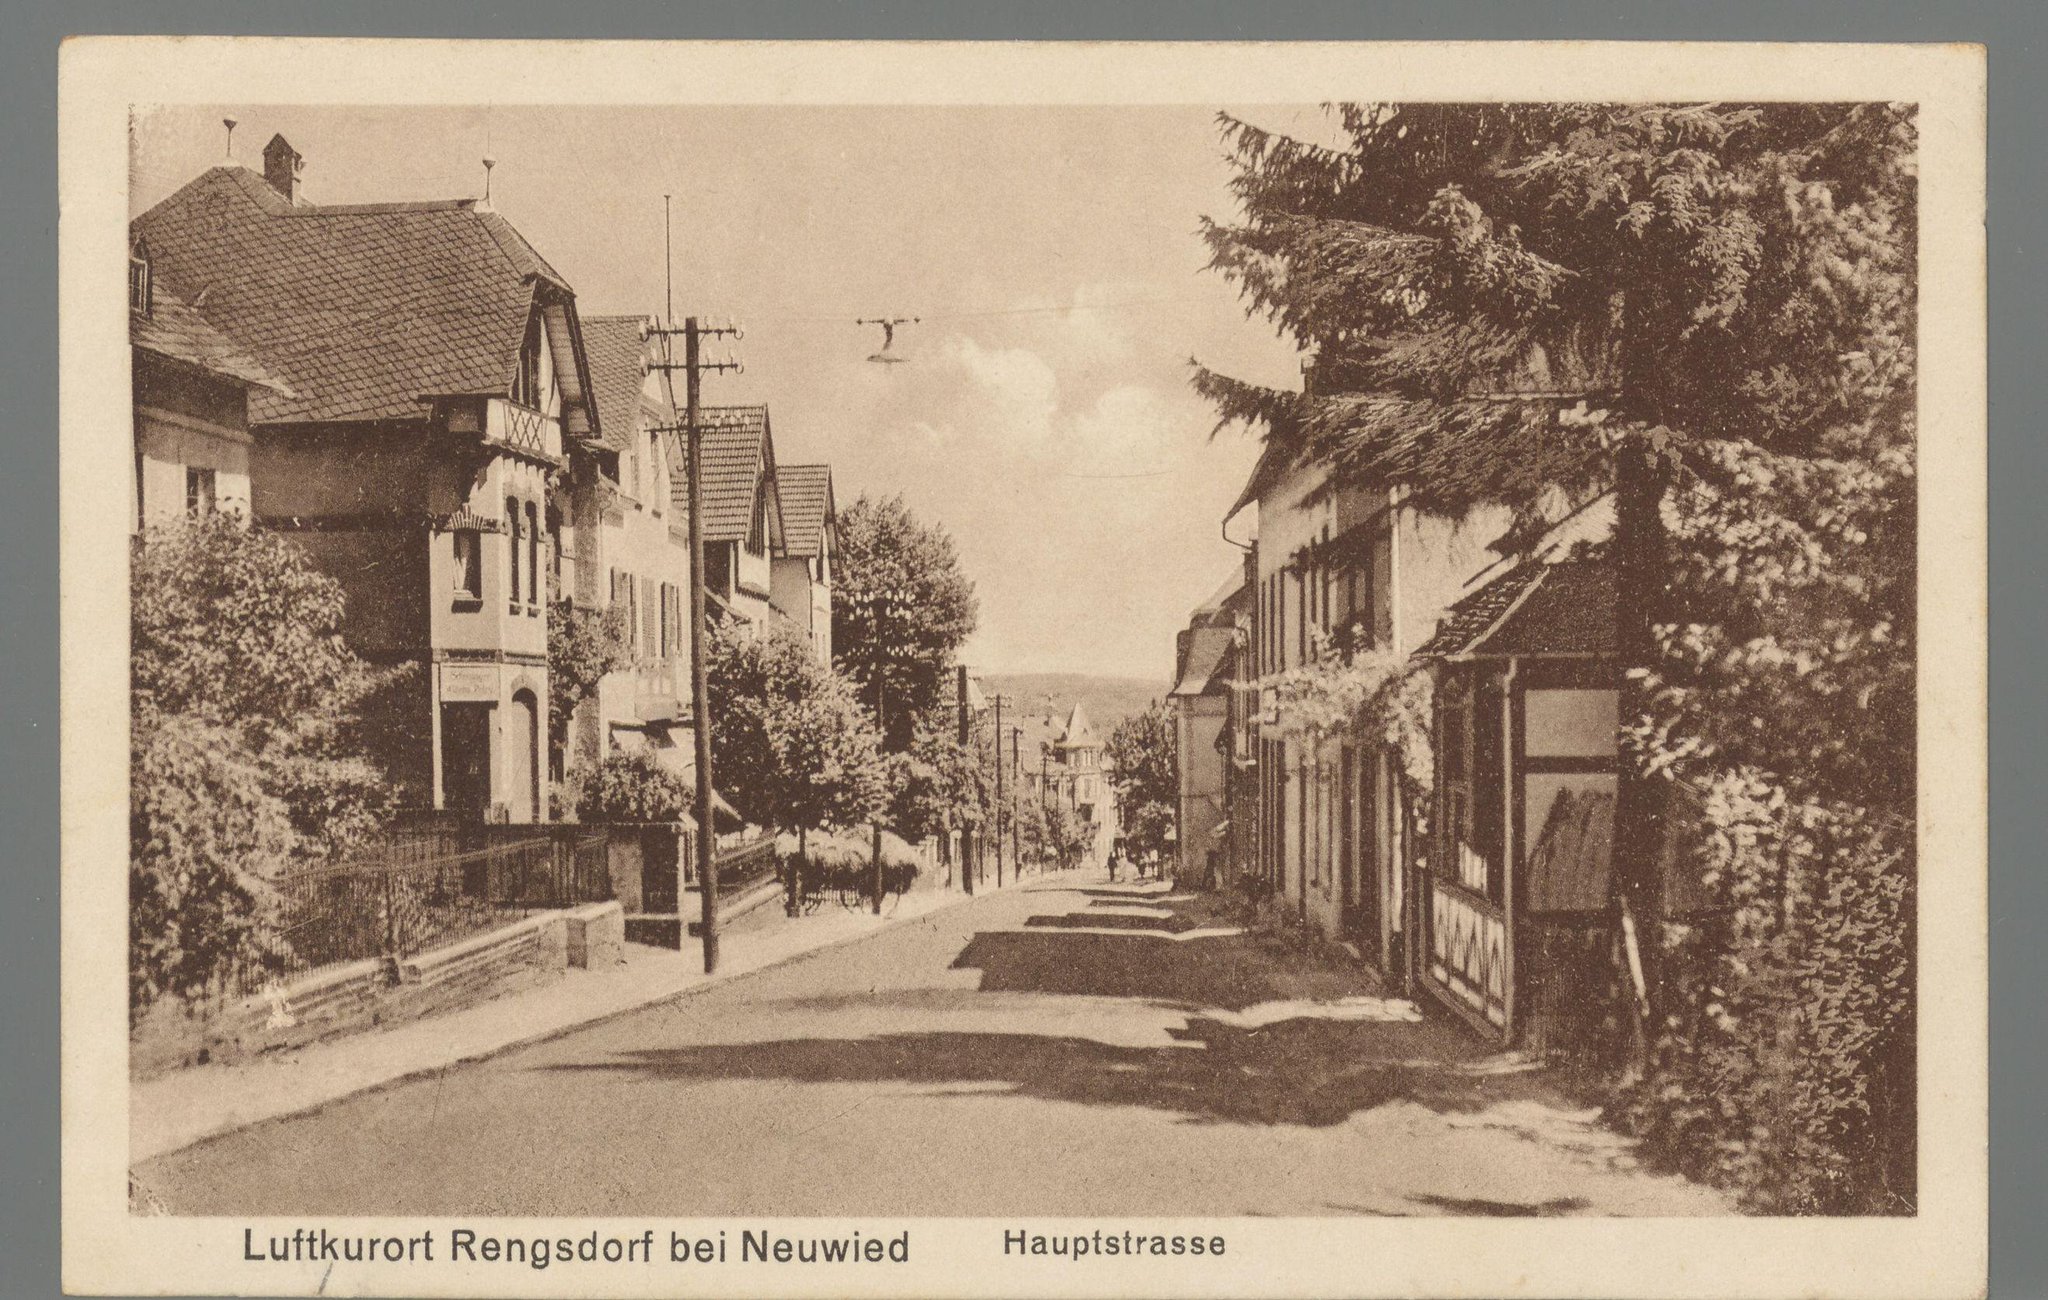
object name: ansichtkaart, prentbriefkaart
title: Luftkurort Rengsdorf bei Neuwied. Hauptstrasse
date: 1905-1930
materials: cardboard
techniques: photograph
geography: rengsdorf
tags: watering-place, spa, street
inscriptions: postage stamp